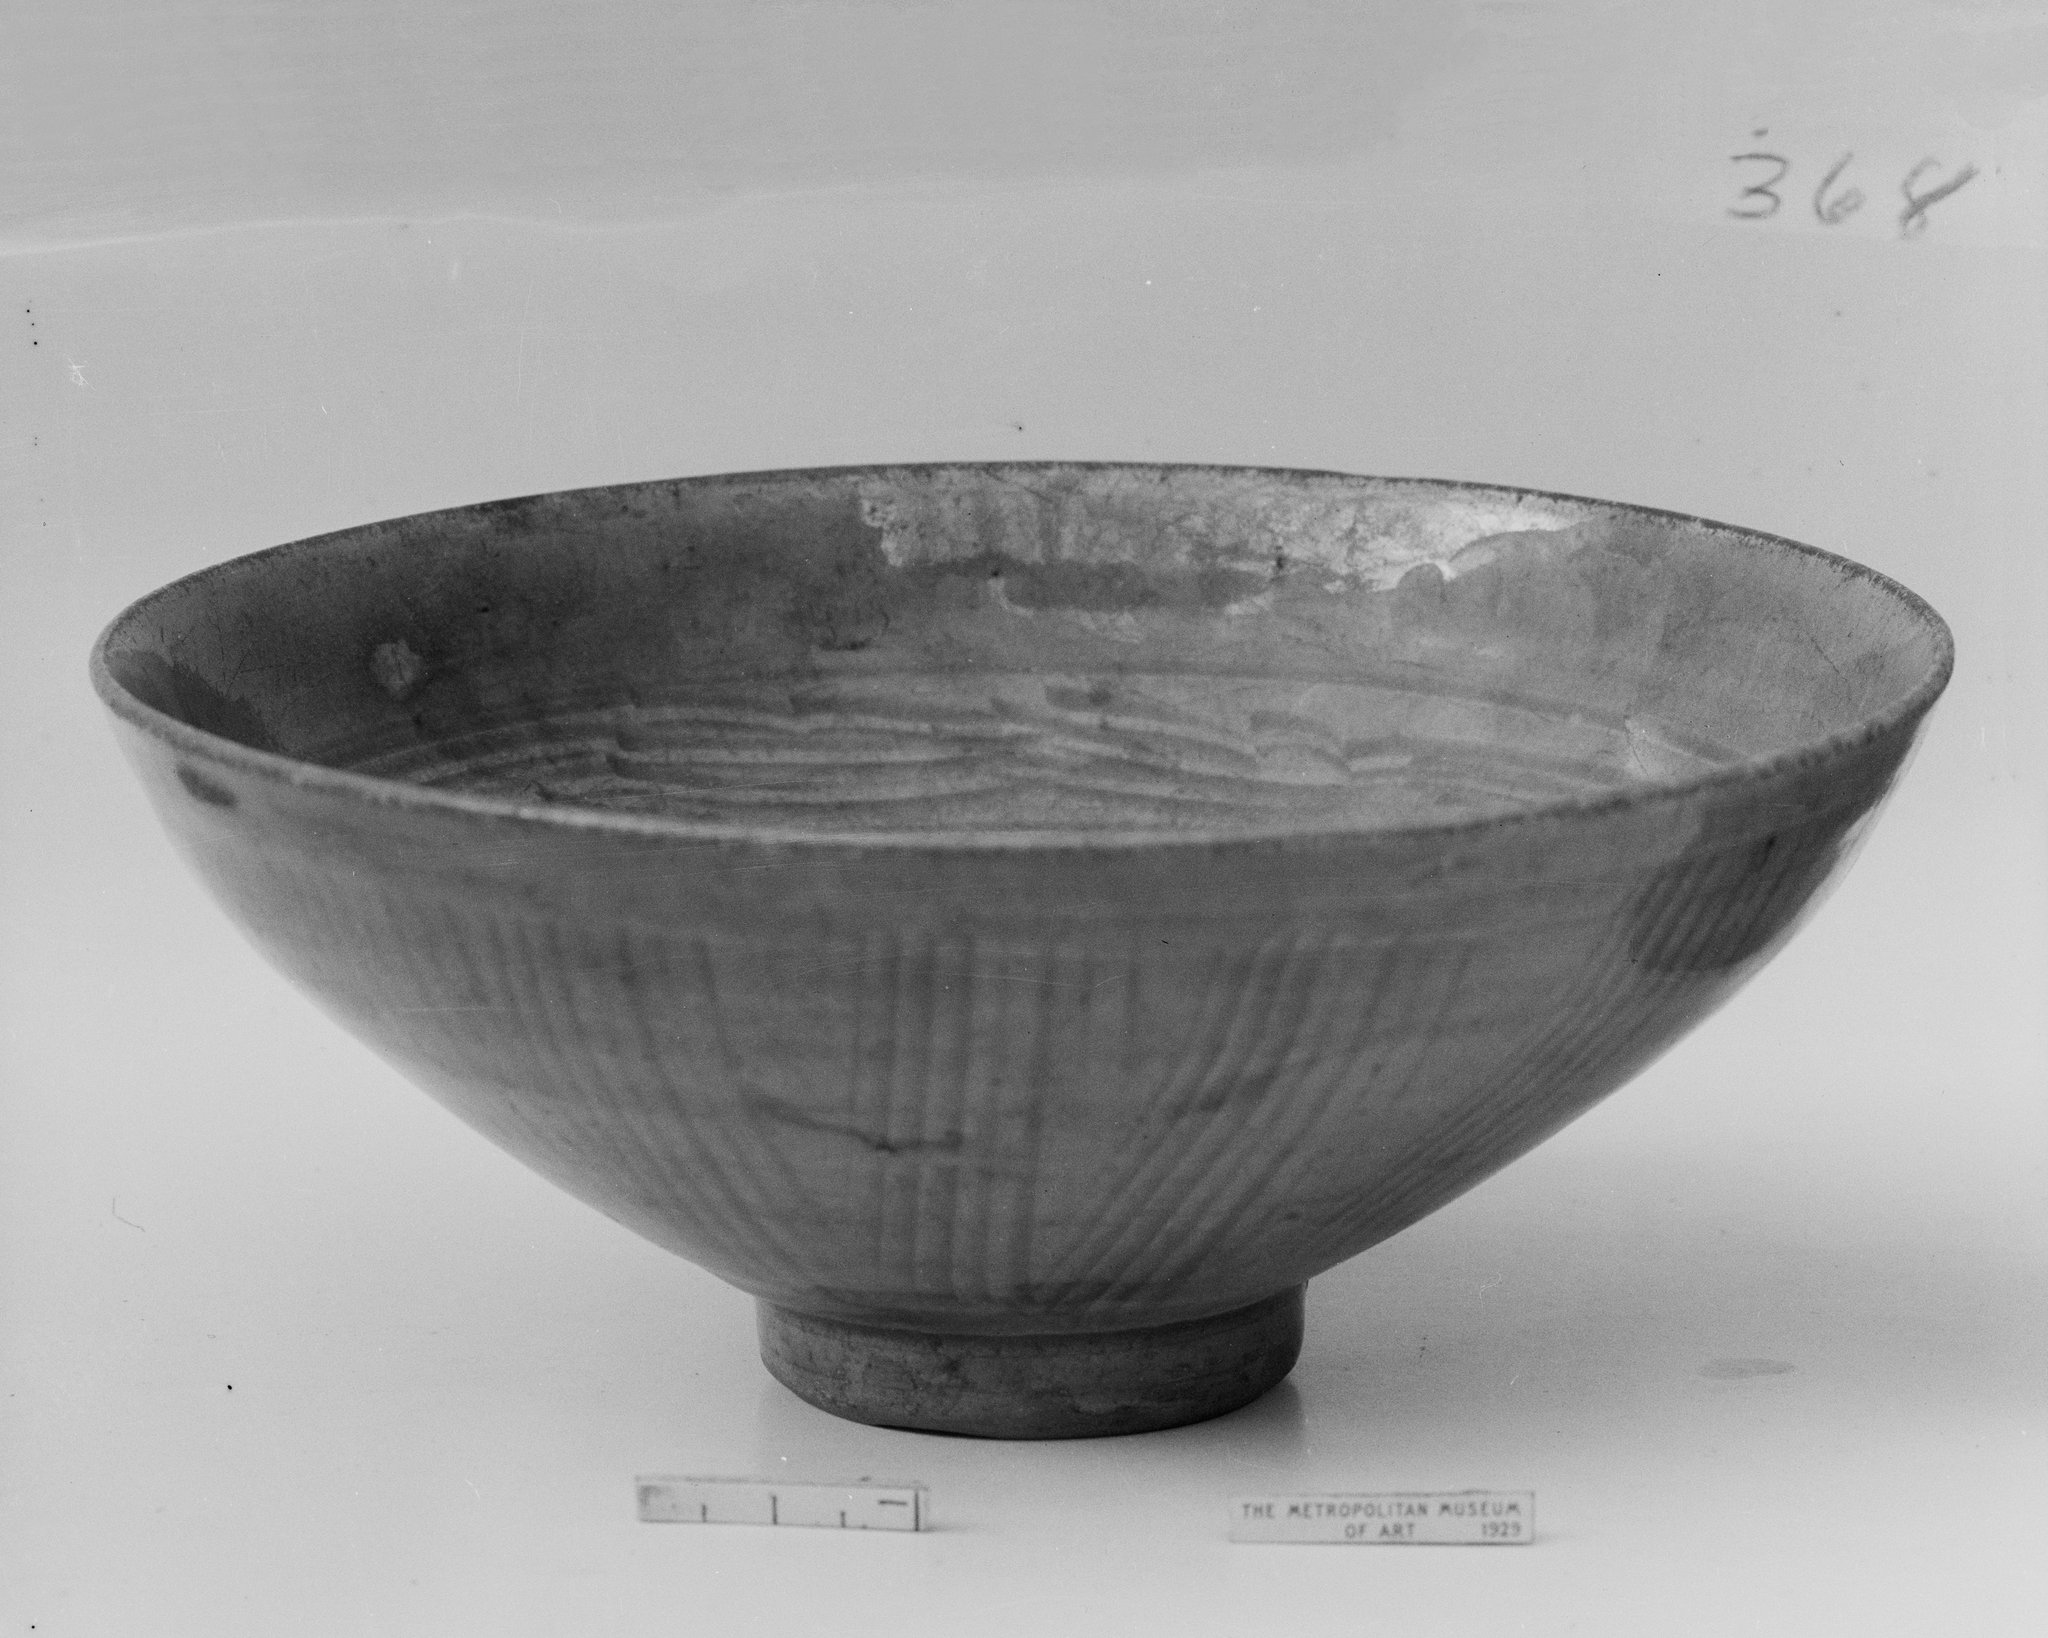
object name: bowl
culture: chinese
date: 960-1279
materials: ceramic glaze, glaze, stoneware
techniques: carving